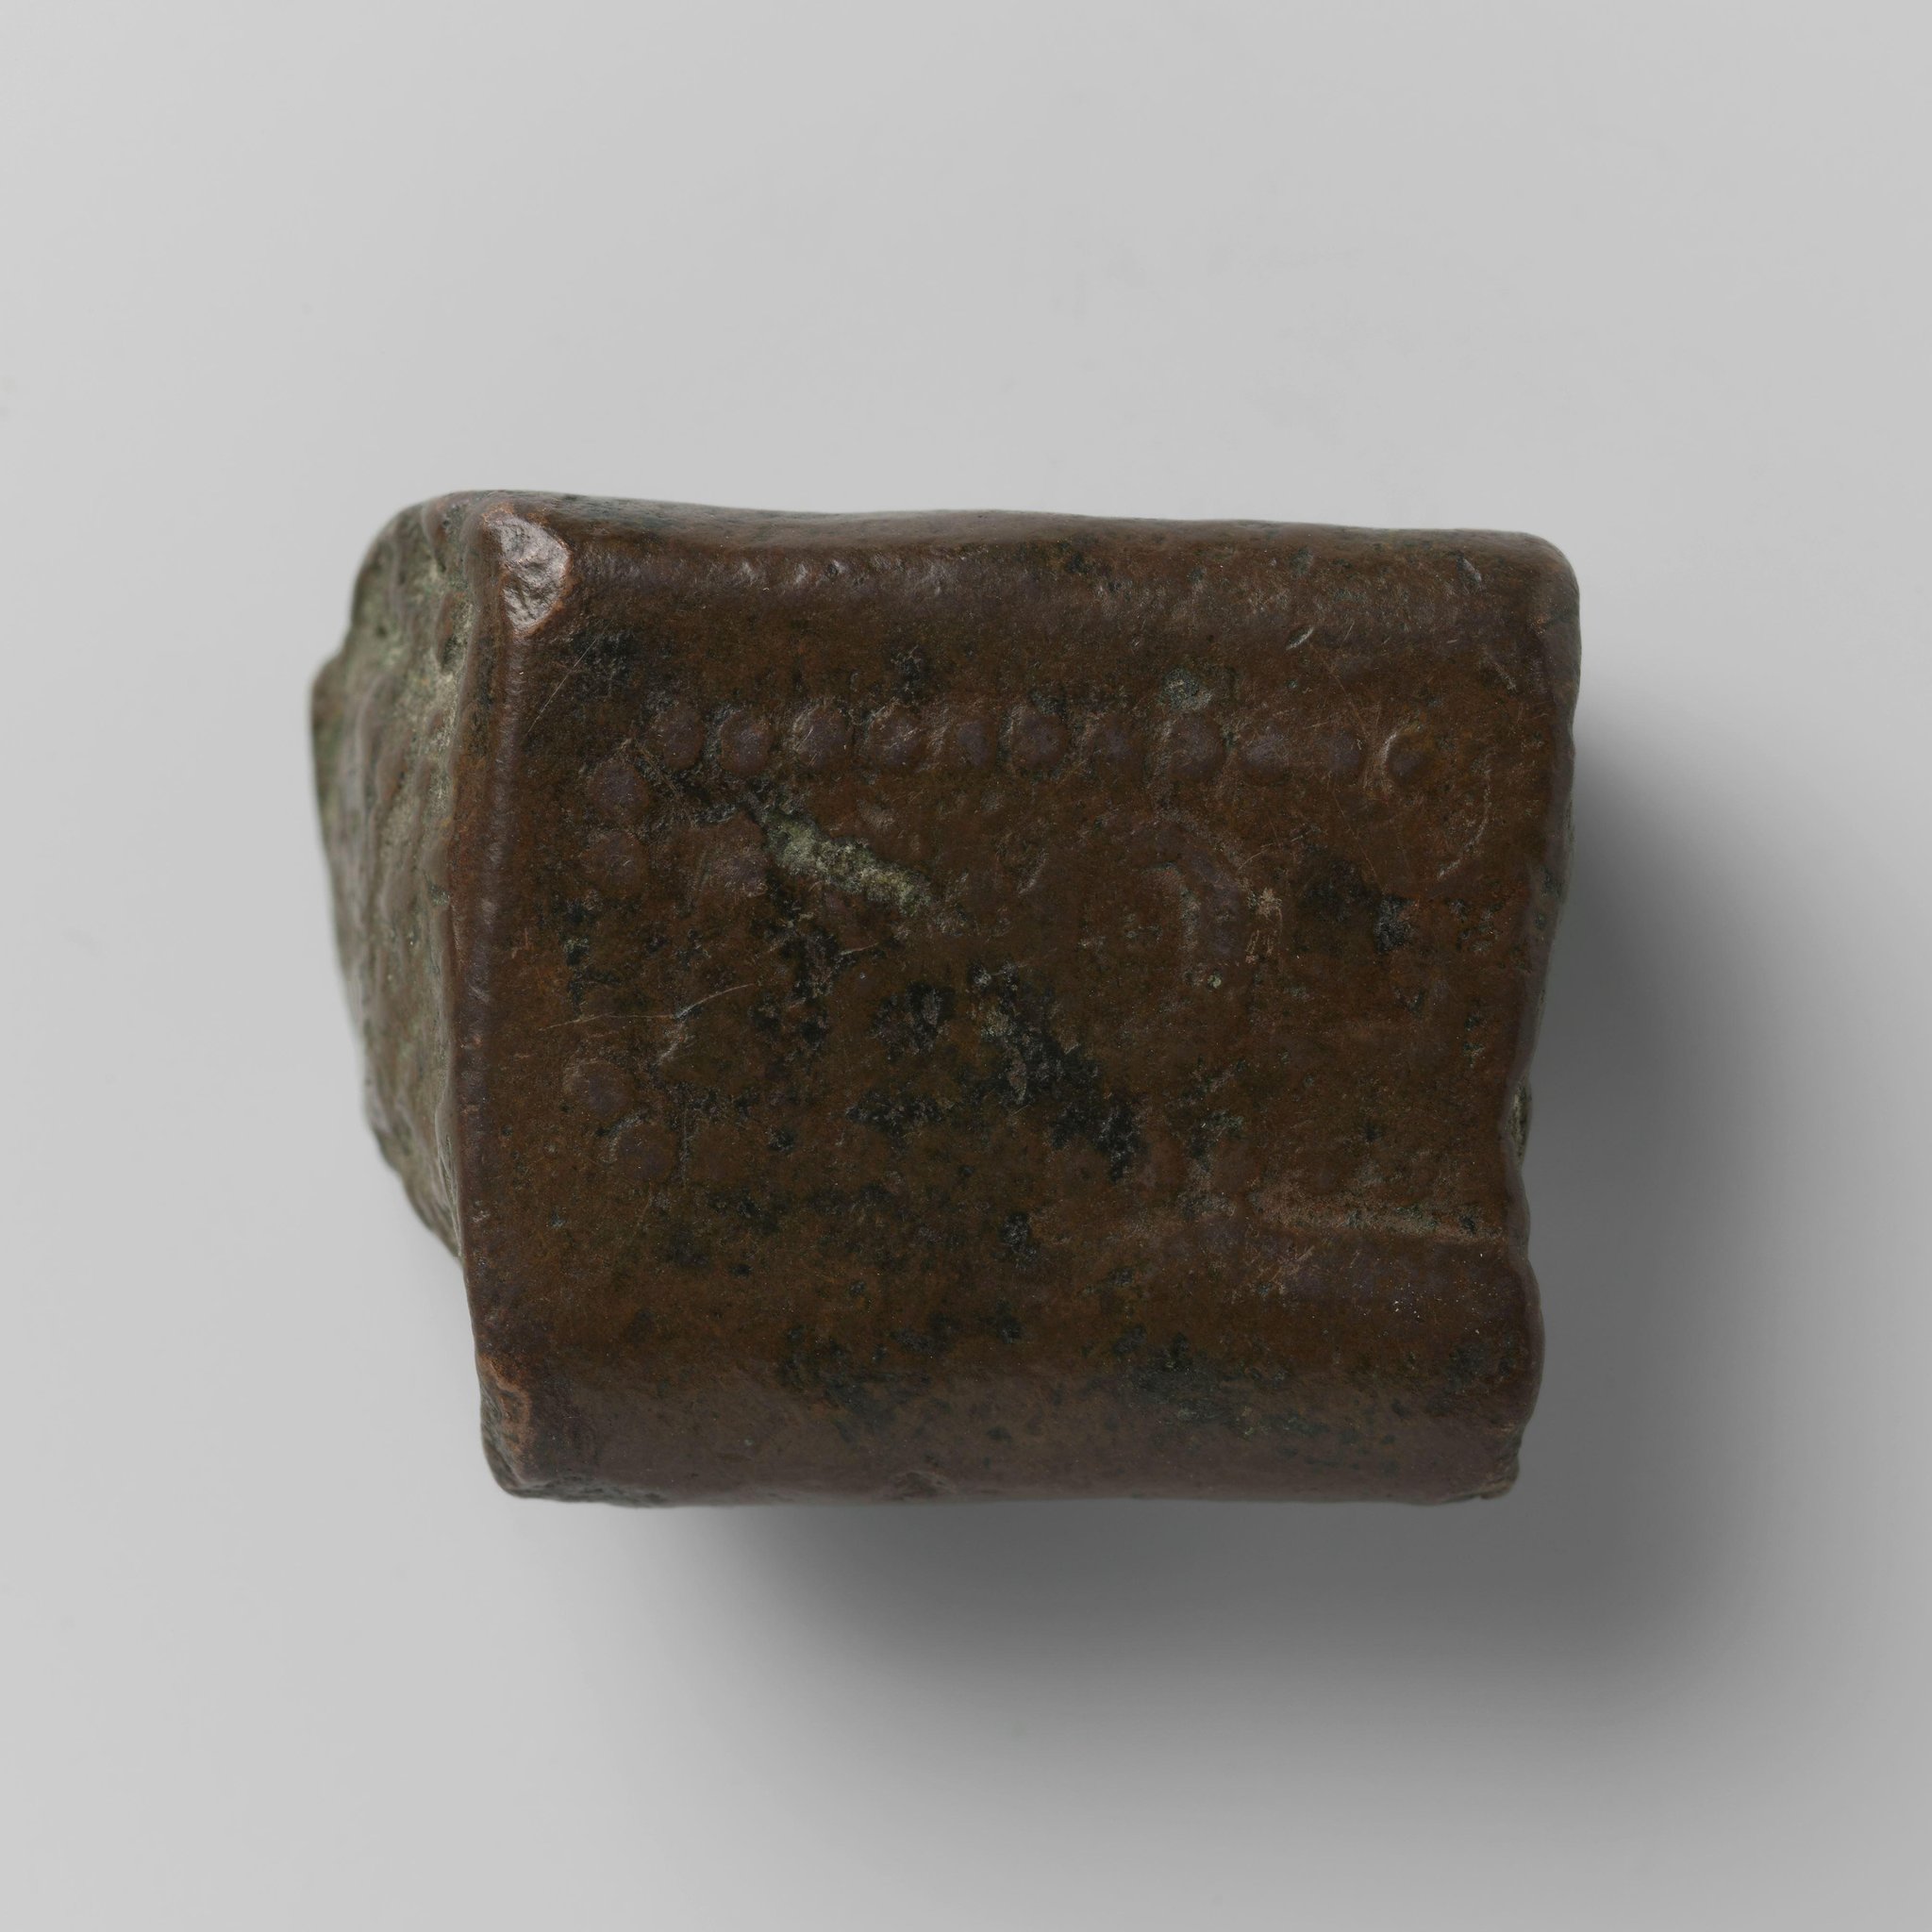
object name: coin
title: Nederlands Indië, 2 stuiver bonk,1805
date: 1805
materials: copper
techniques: striking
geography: batavia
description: Koperen rechthoekige munt. Voorzijde: binnen een rechthoekige lijst van parels waarde-aanduiding 2 S. Keerzijde: binnen een rechthoekige lijst van parels jaartal.